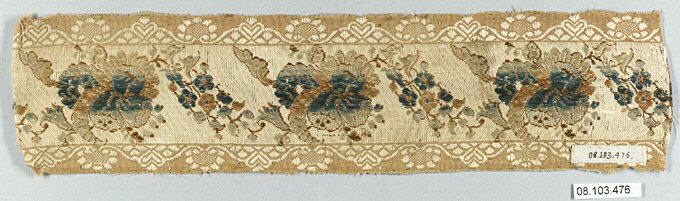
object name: galloon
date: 1830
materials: silk